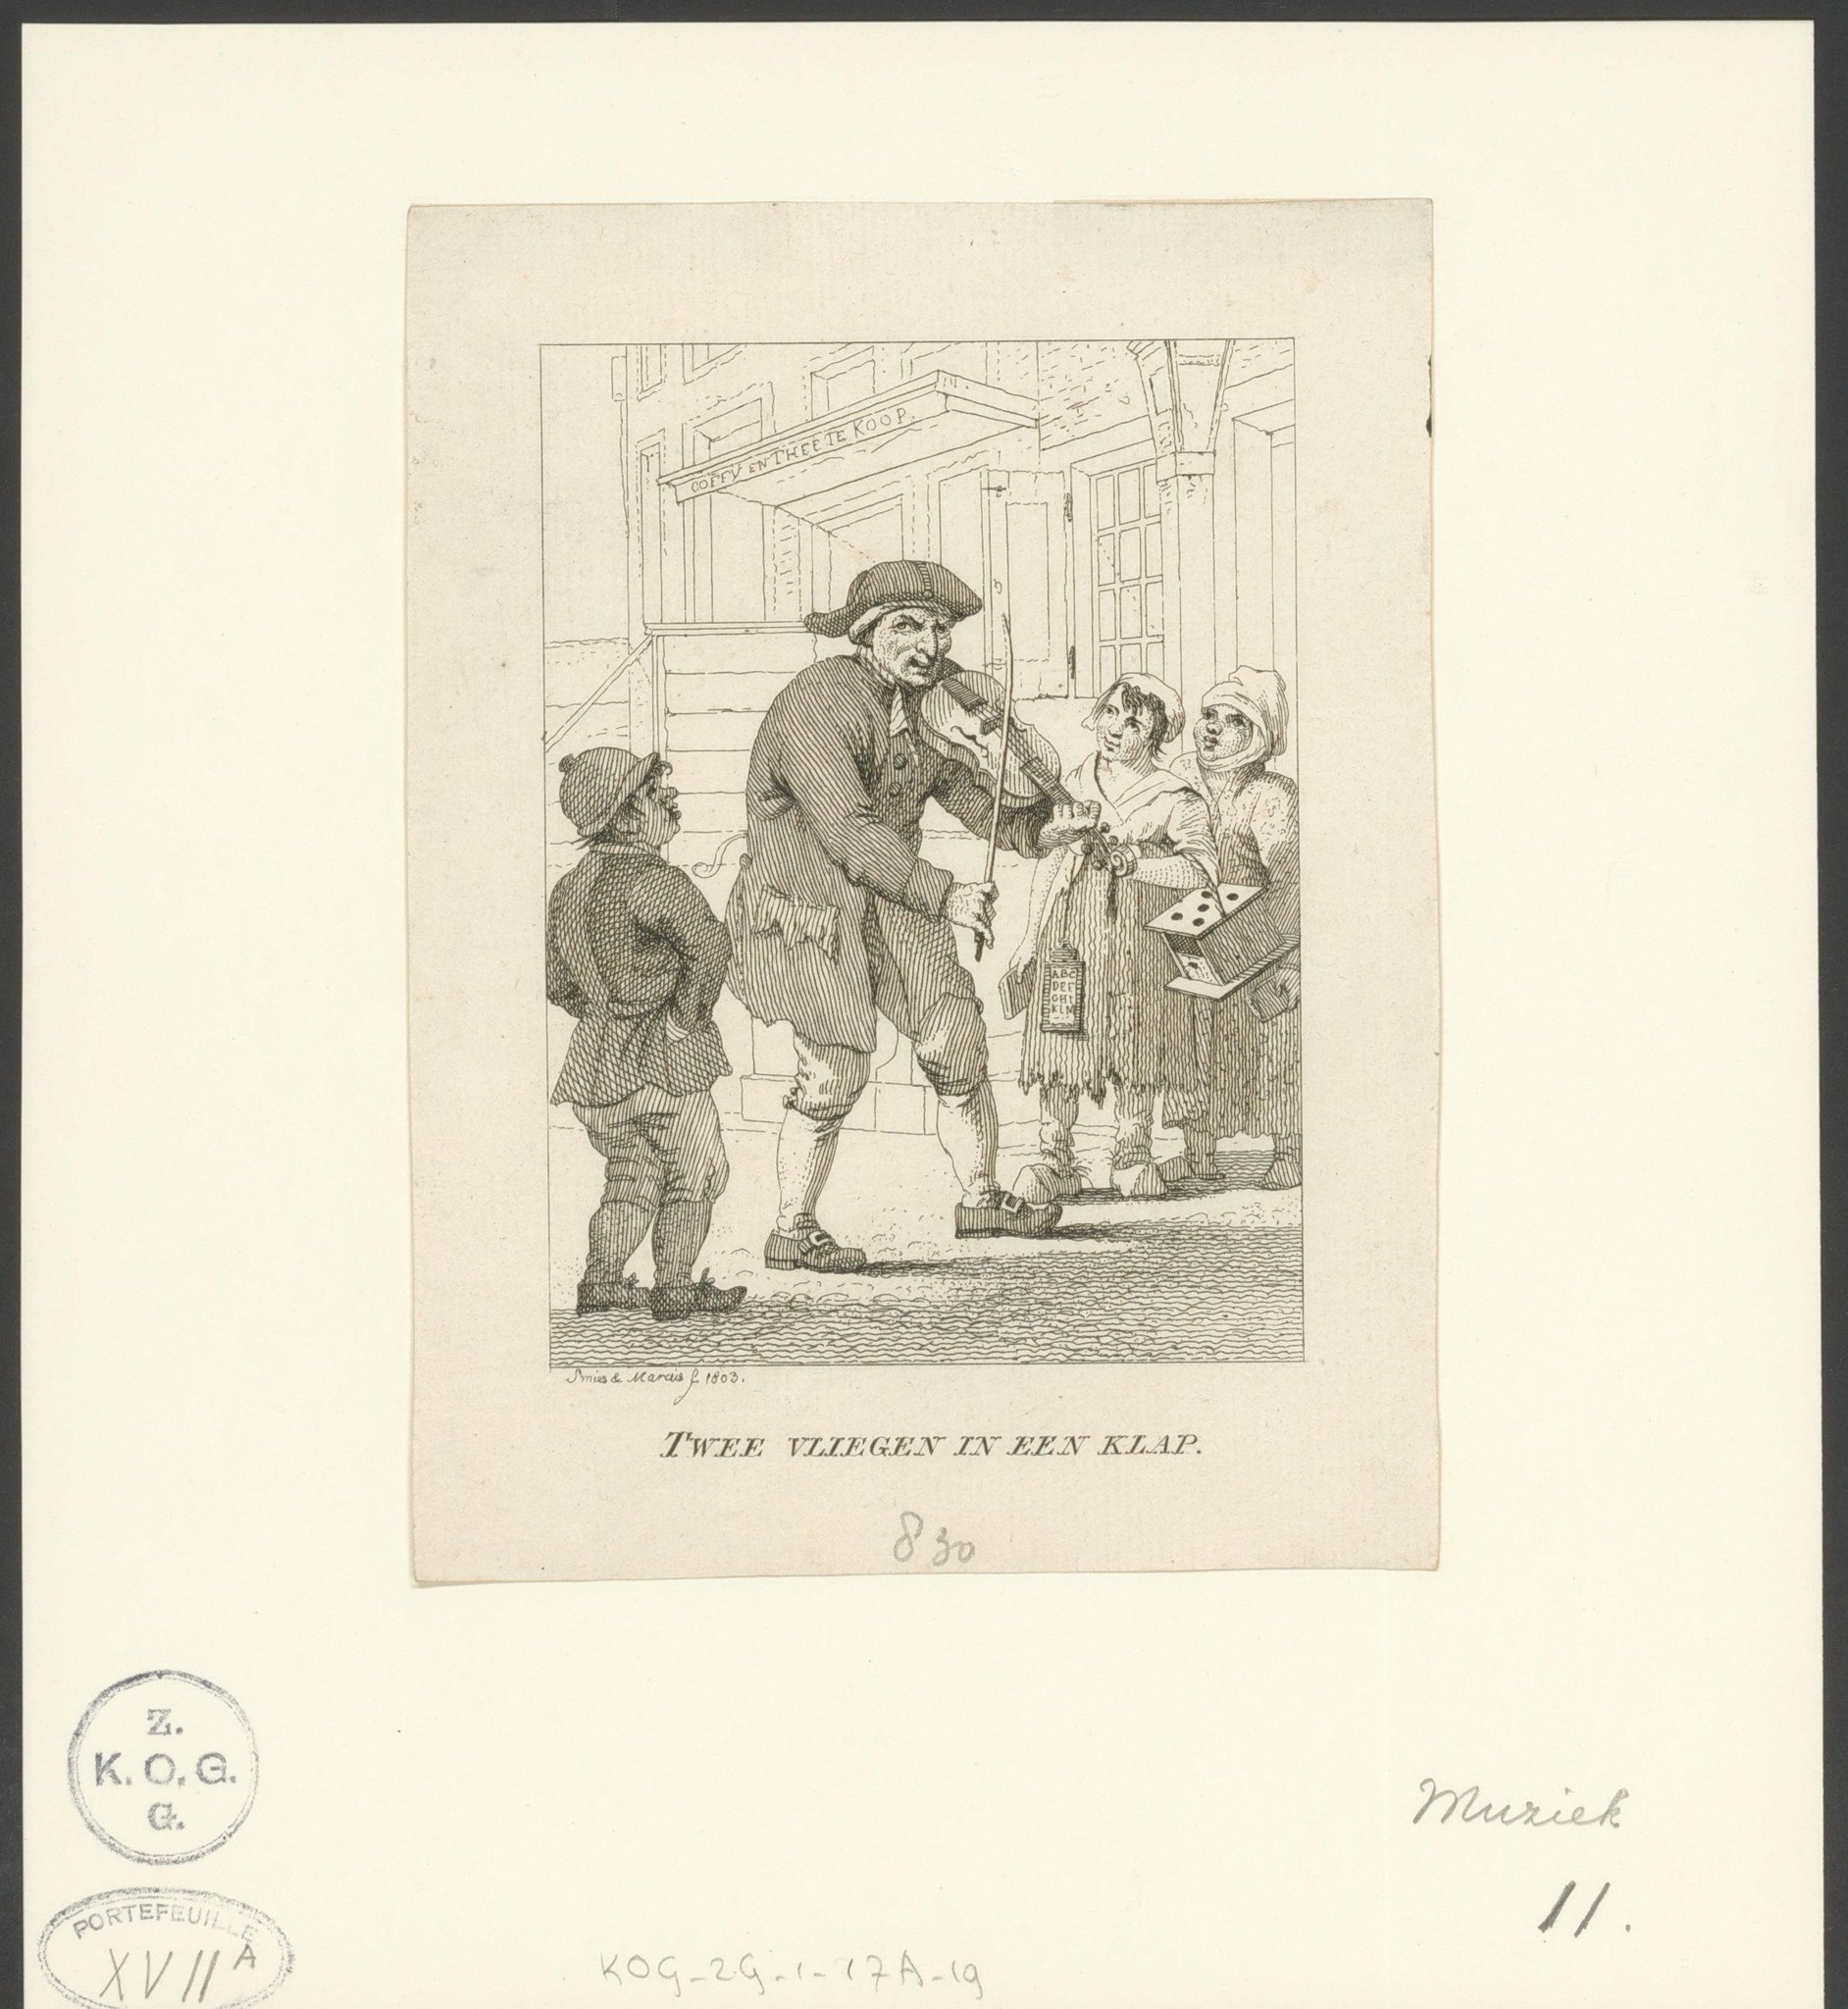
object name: print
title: Vioolspelende straatmuzikant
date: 1803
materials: paper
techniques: etching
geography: netherlands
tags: one person playing string instrument (bowed) - cc - out of doors, instrumental popular music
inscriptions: collector's mark: Lugt 1641, stamp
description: Een straatmuzikant met een viool. Links van hem een jongen, rechts twee meisjes op klompen. De voorste met een stoof aan de arm en plankje of leitje met het alfabet. Op de achtergrond een koffie- en theewinkel. Onderdeel van een serie van acht prenten met als doel contrasten van het toenmalige werkelijke leven ca. 1800 met de beschaafde wereld (beau-monde) te tonen. Onderwerpsrubrieken binnen de Atlas Zeden en Gewoonten: Muziek en muziekinstrumenten: Strijk- en snaarinstrumenten.